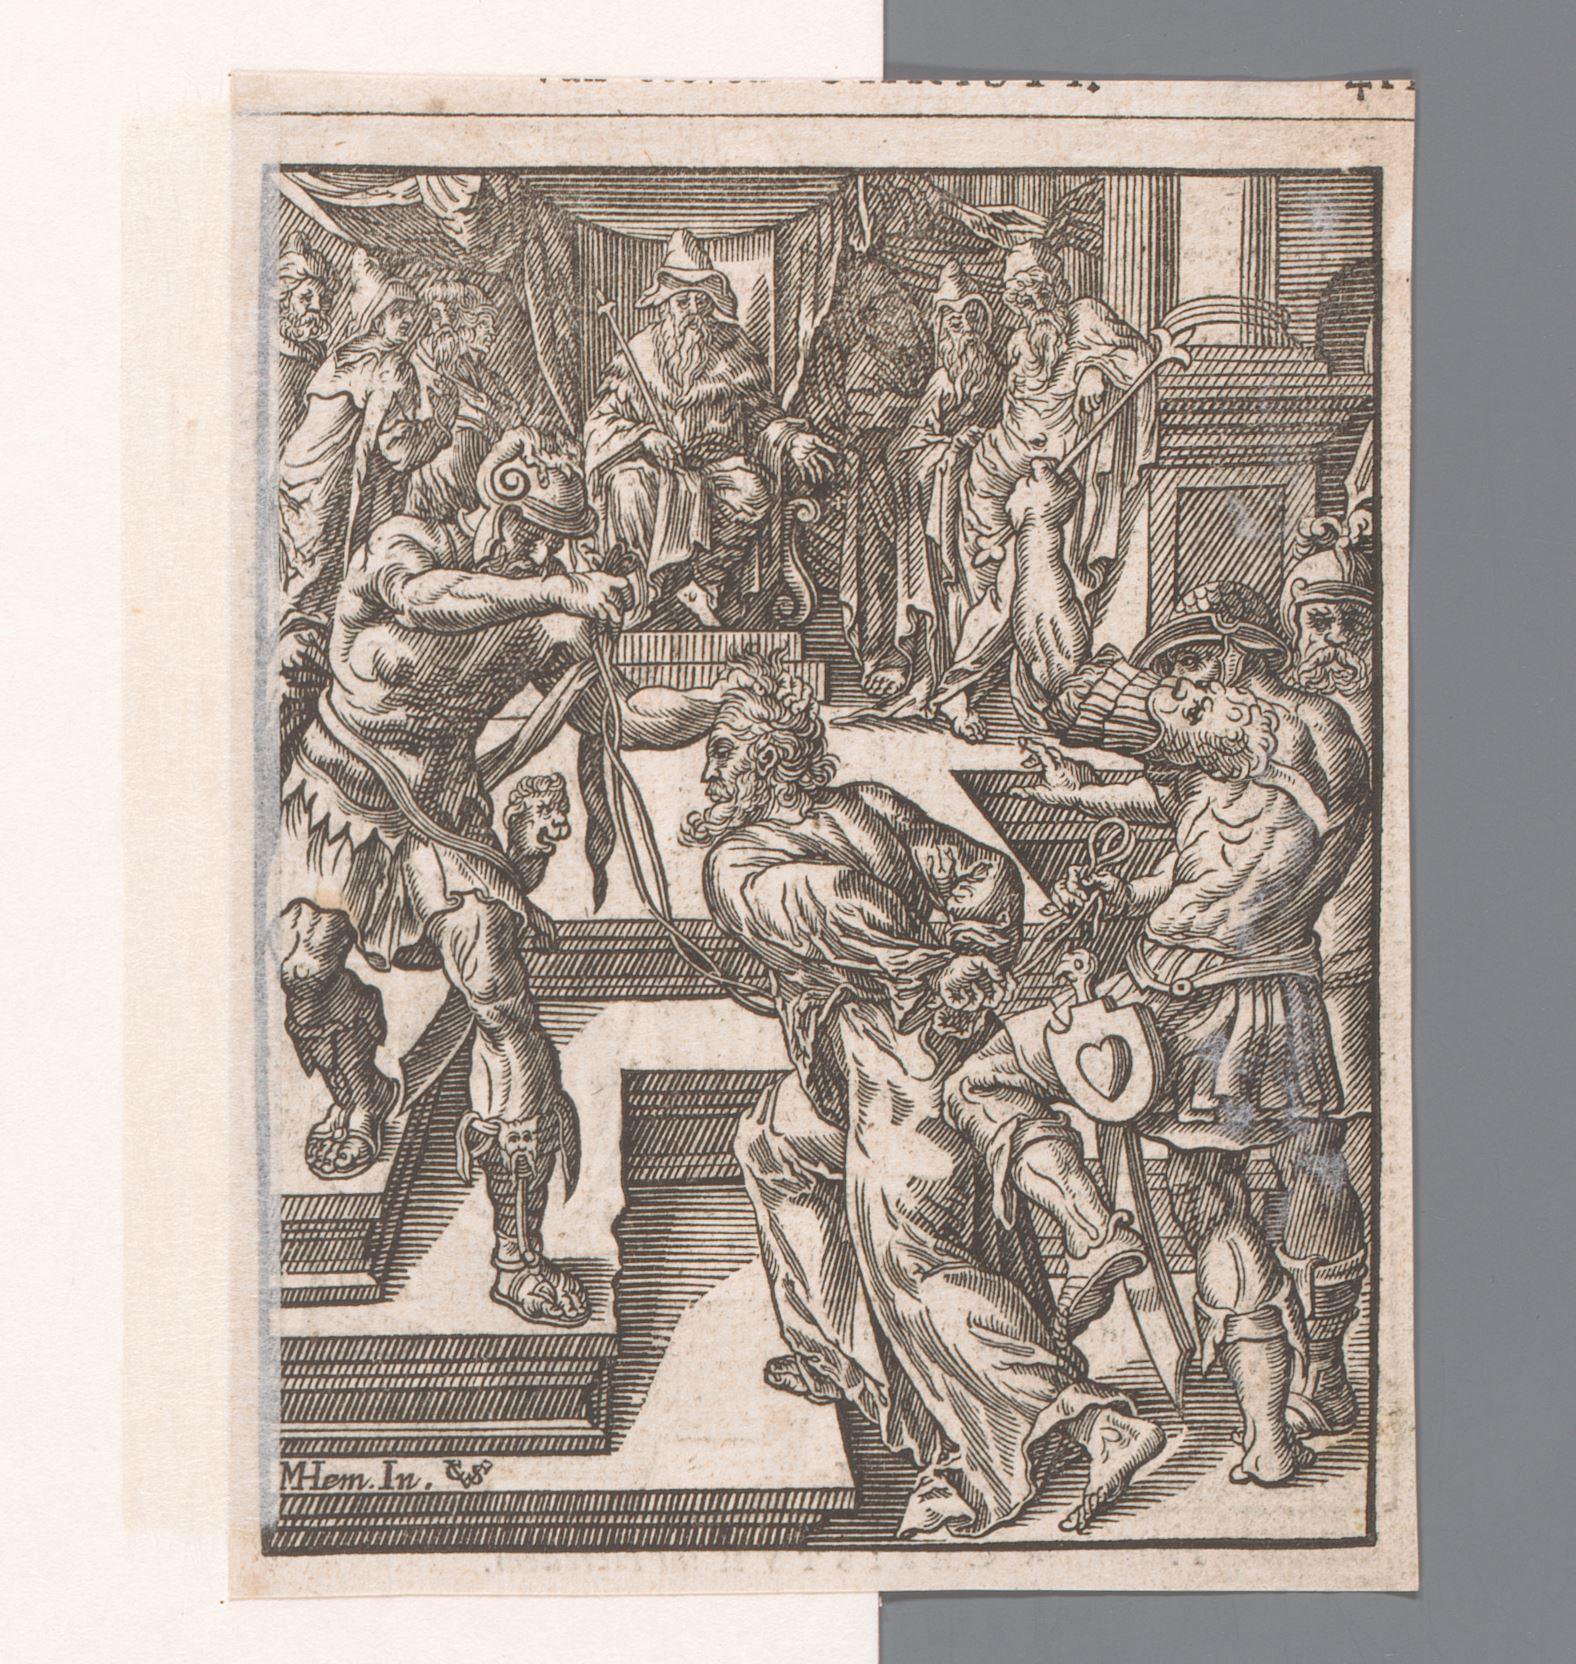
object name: print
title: Christus voor Kajafas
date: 1648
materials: paper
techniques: letterpress printing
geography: haarlem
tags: christ before the sanhedrin with caiaphas as high priest, and possibly annas; maybe a soldier about to strike christ because he keeps silent (matthew 26:57-66; mark 14:53-64; luke 22:54, 22:66-71)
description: Prent uit: 't Schat der Zielen, dat is, het geheele leven ons Heeren Iesu Christi naer de vyer Evangelisten (...) in zeven stucken verdeelt. Amsterdam: Pieter Jacobsz. Paets, 1648. Deze prent komt uit het vijfde deel of hoofdstuk van 't Schat der zielen: Passie ons Heeren Iesu Christi, naer de beschrijvinghe van de vier evangelisten. Binnen het vijfde deel hoort deze prent bij de beschrijving van de passie door Lucas.